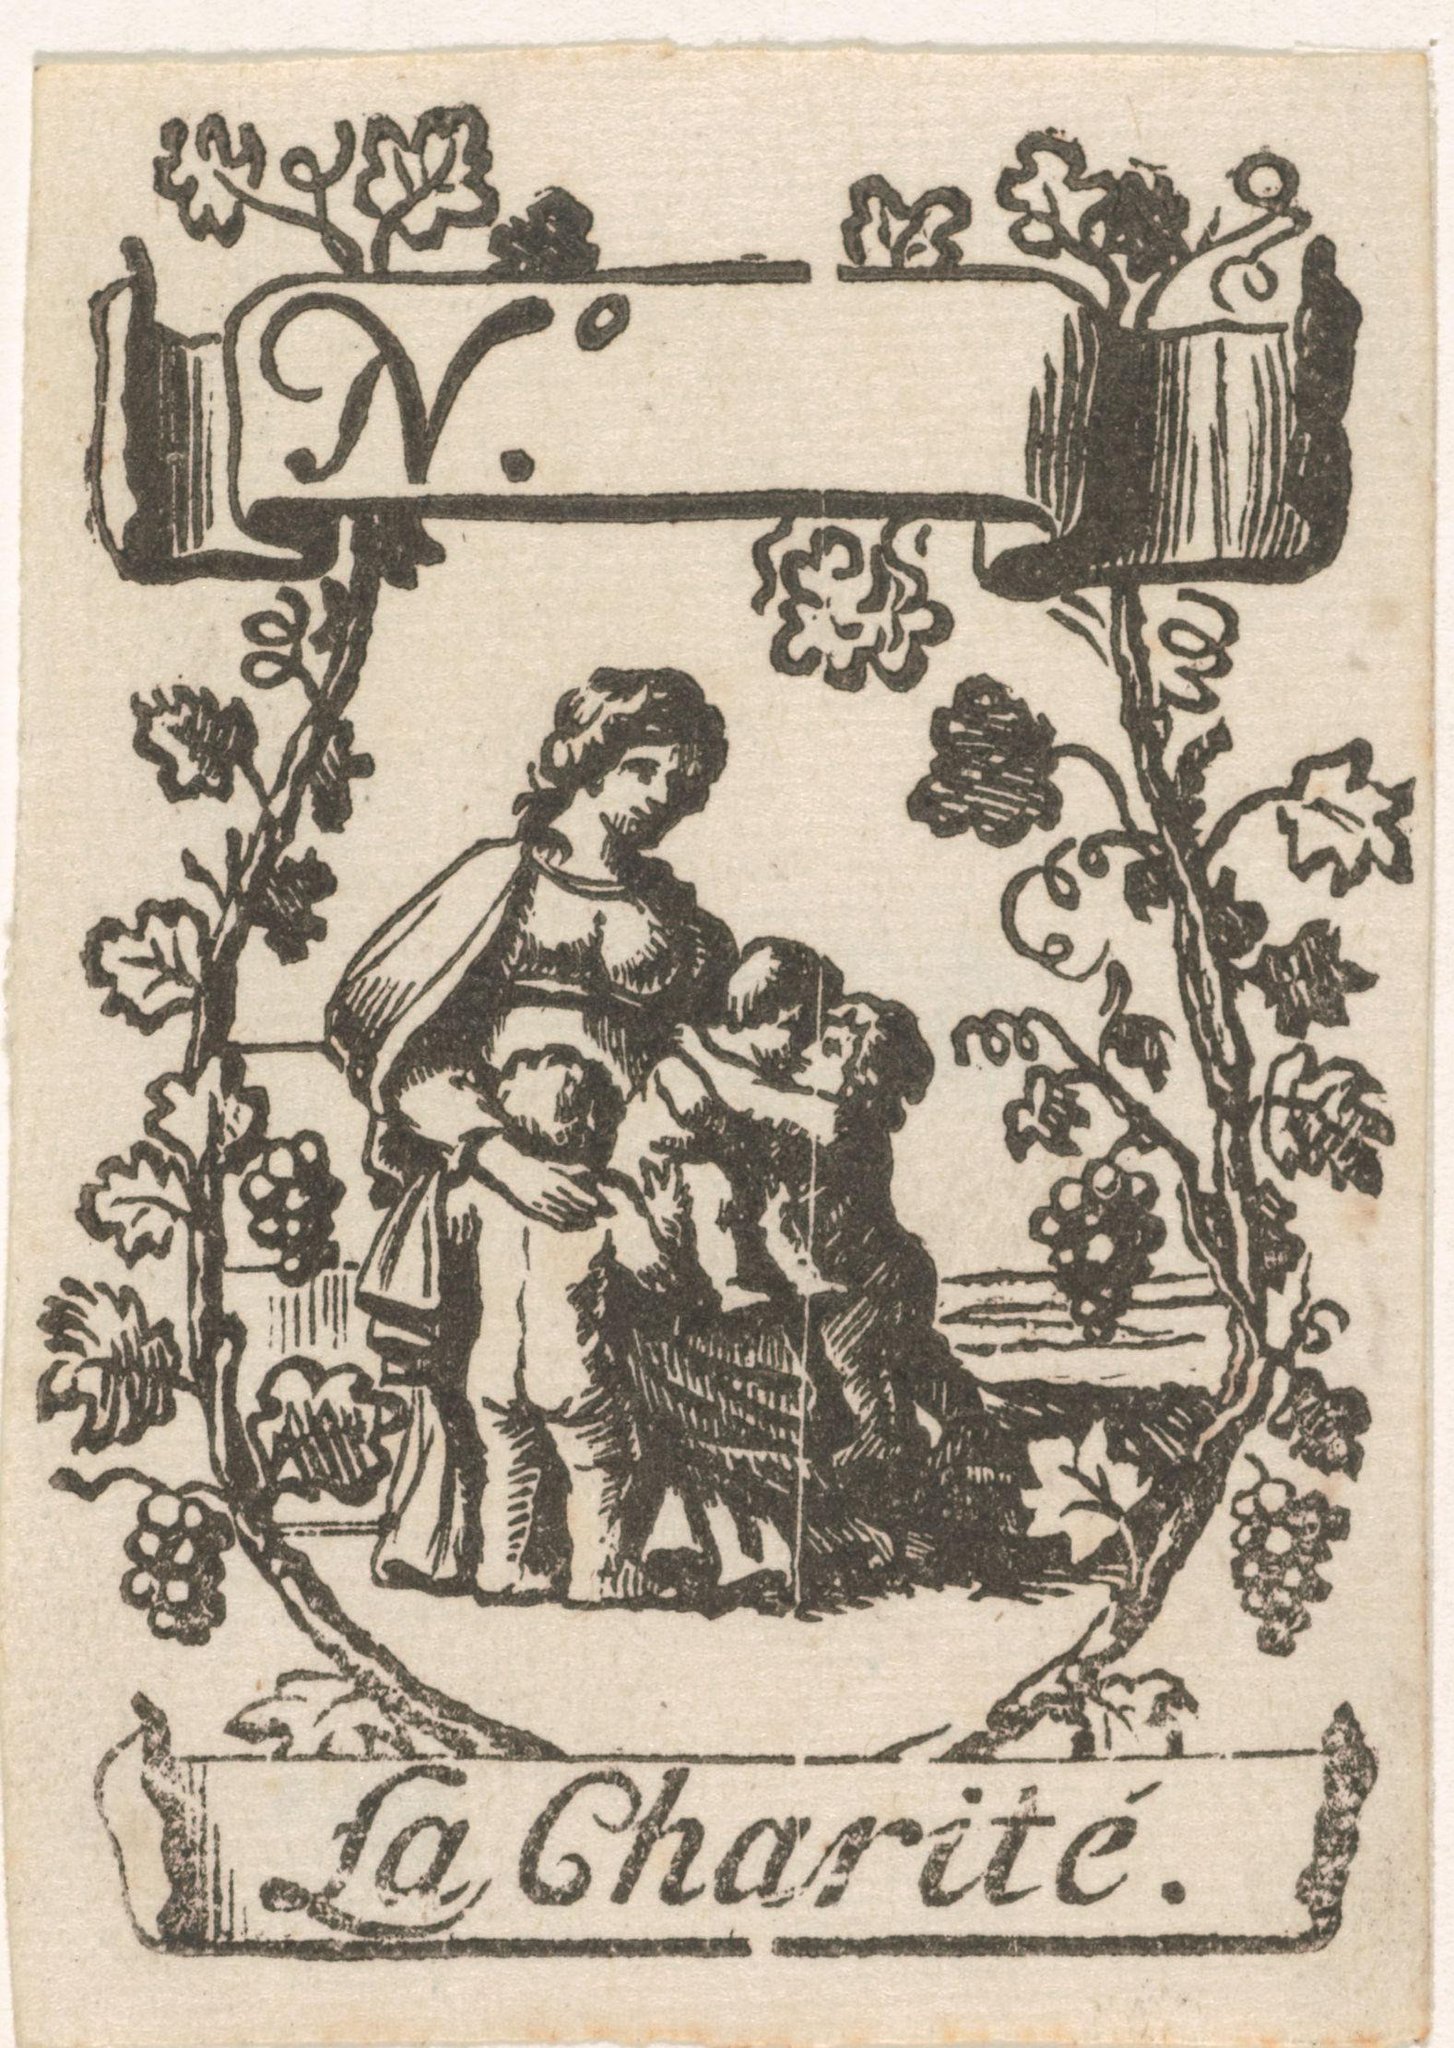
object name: handelsetiket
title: La Charité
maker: isaac vincentsz. van der vinne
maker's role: draughtsman, print maker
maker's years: 1665-1740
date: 1681-1740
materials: paper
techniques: woodcut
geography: haarlem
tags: charity, 'caritas'; 'carità' (ripa) ~ one of the three theological virtues, vignette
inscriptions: collector's mark: Lugt 240